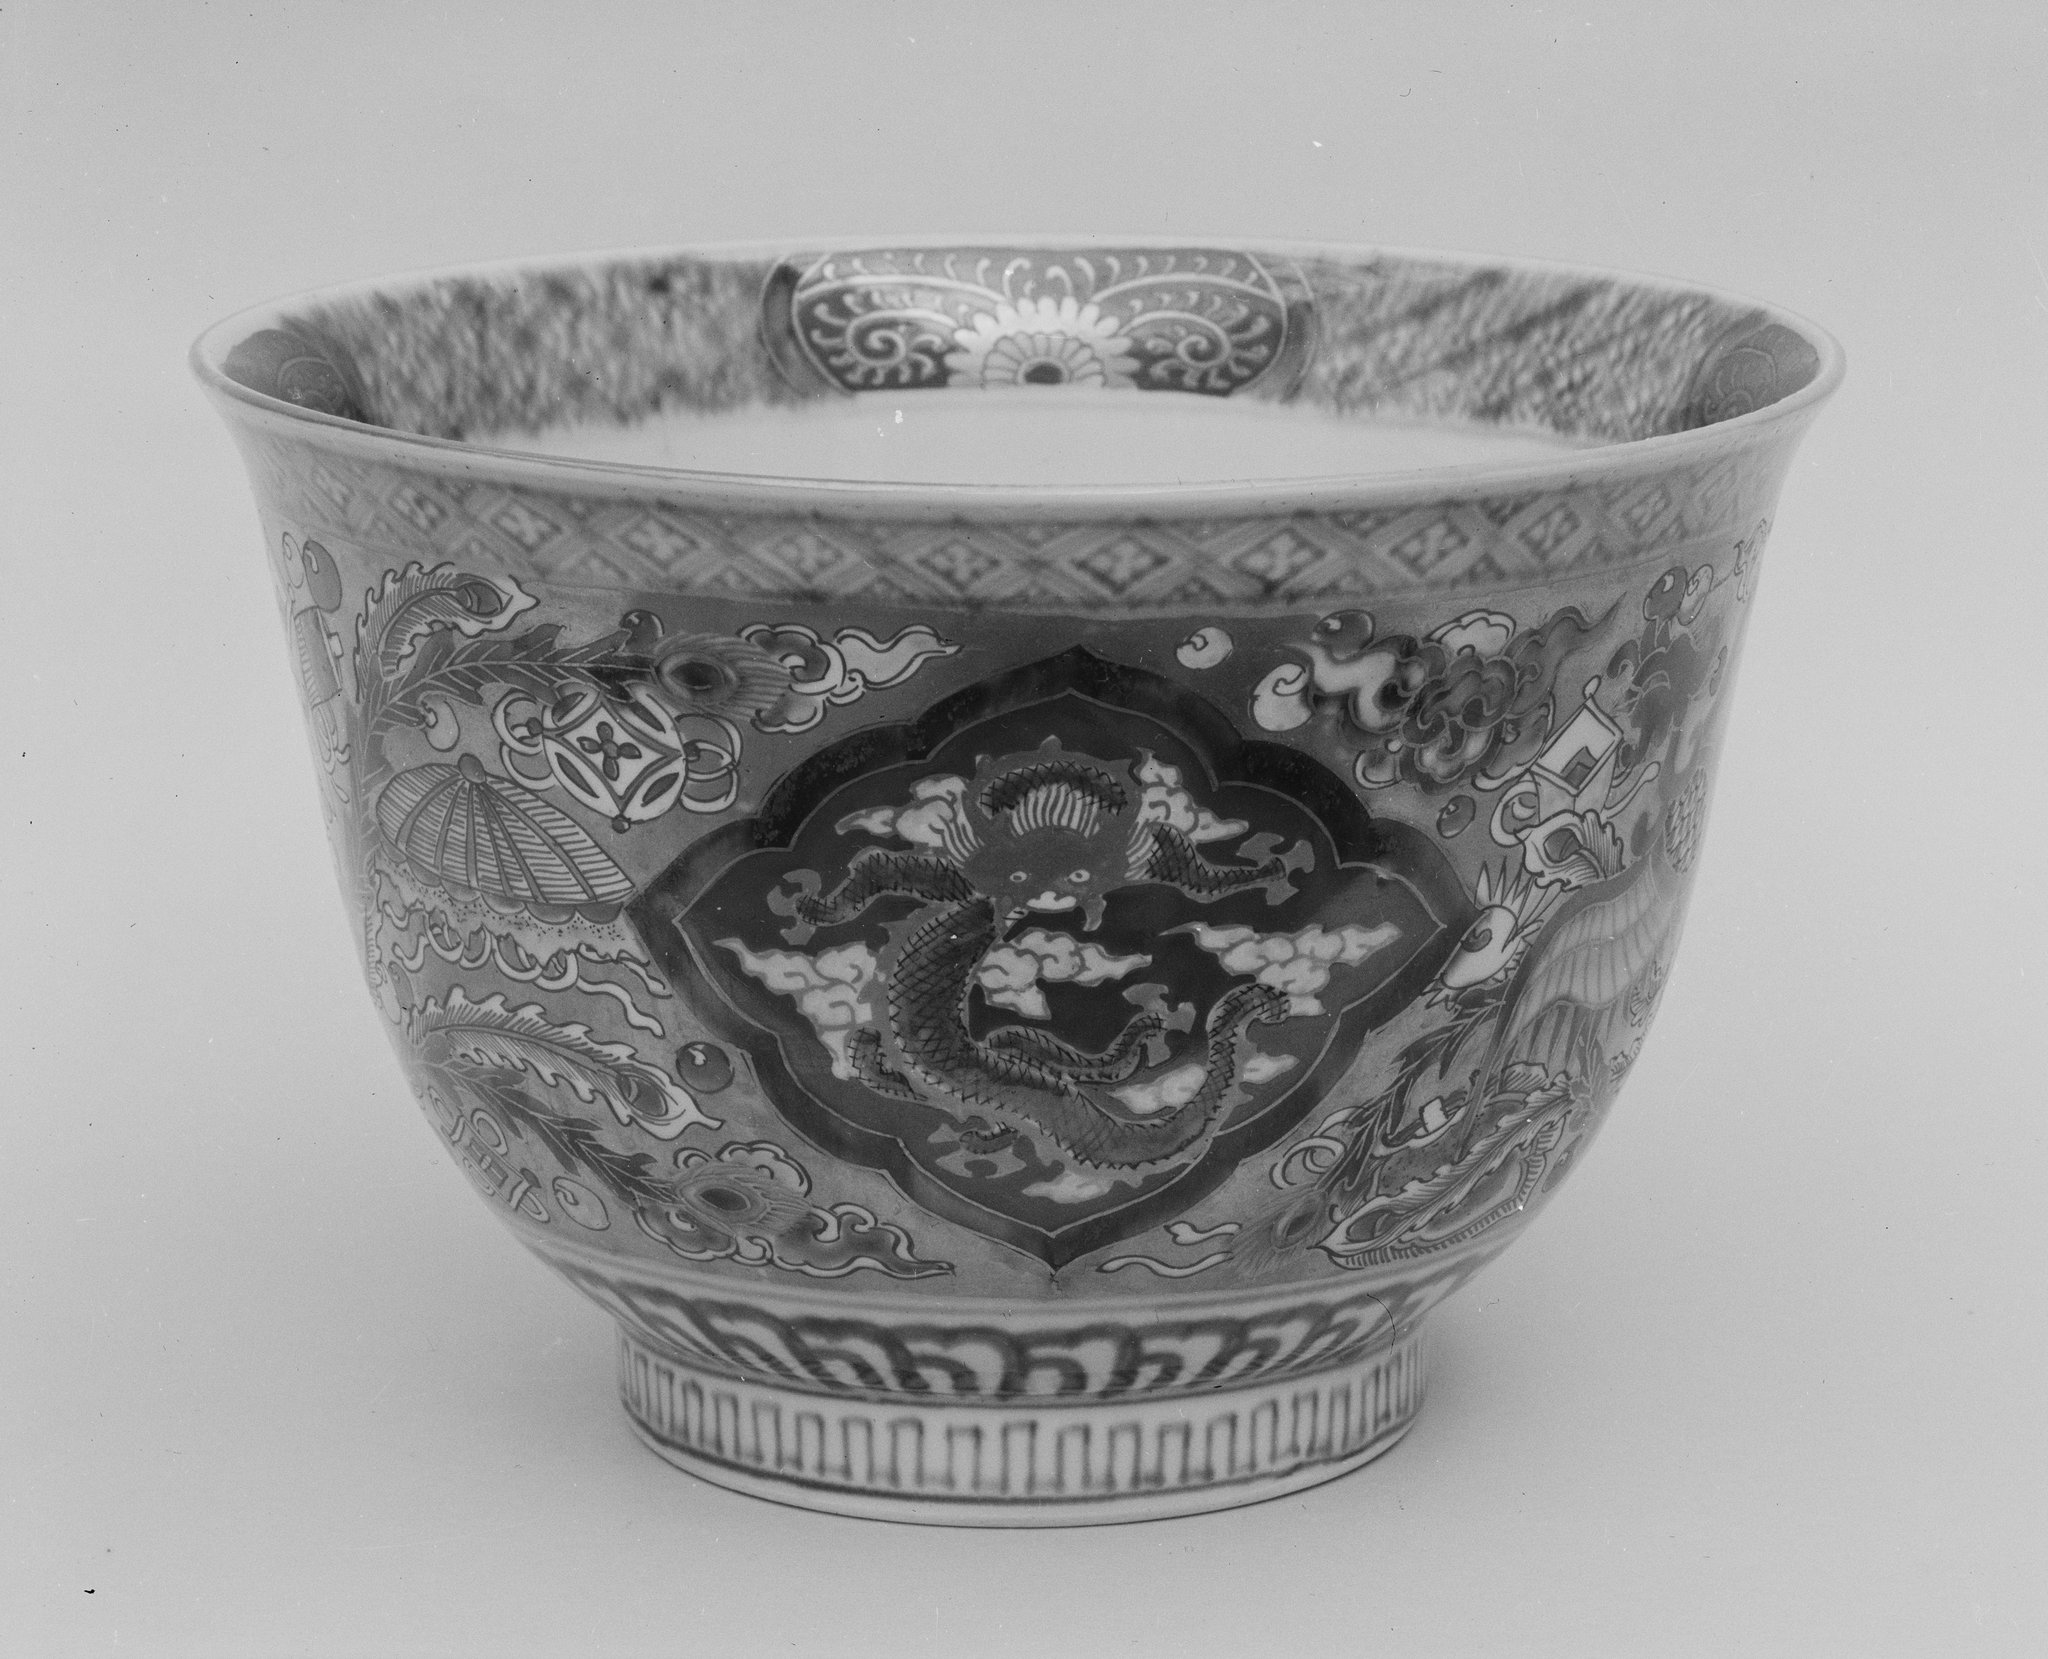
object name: bowl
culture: japanese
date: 1701-1900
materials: gilt, porcelain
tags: dragons